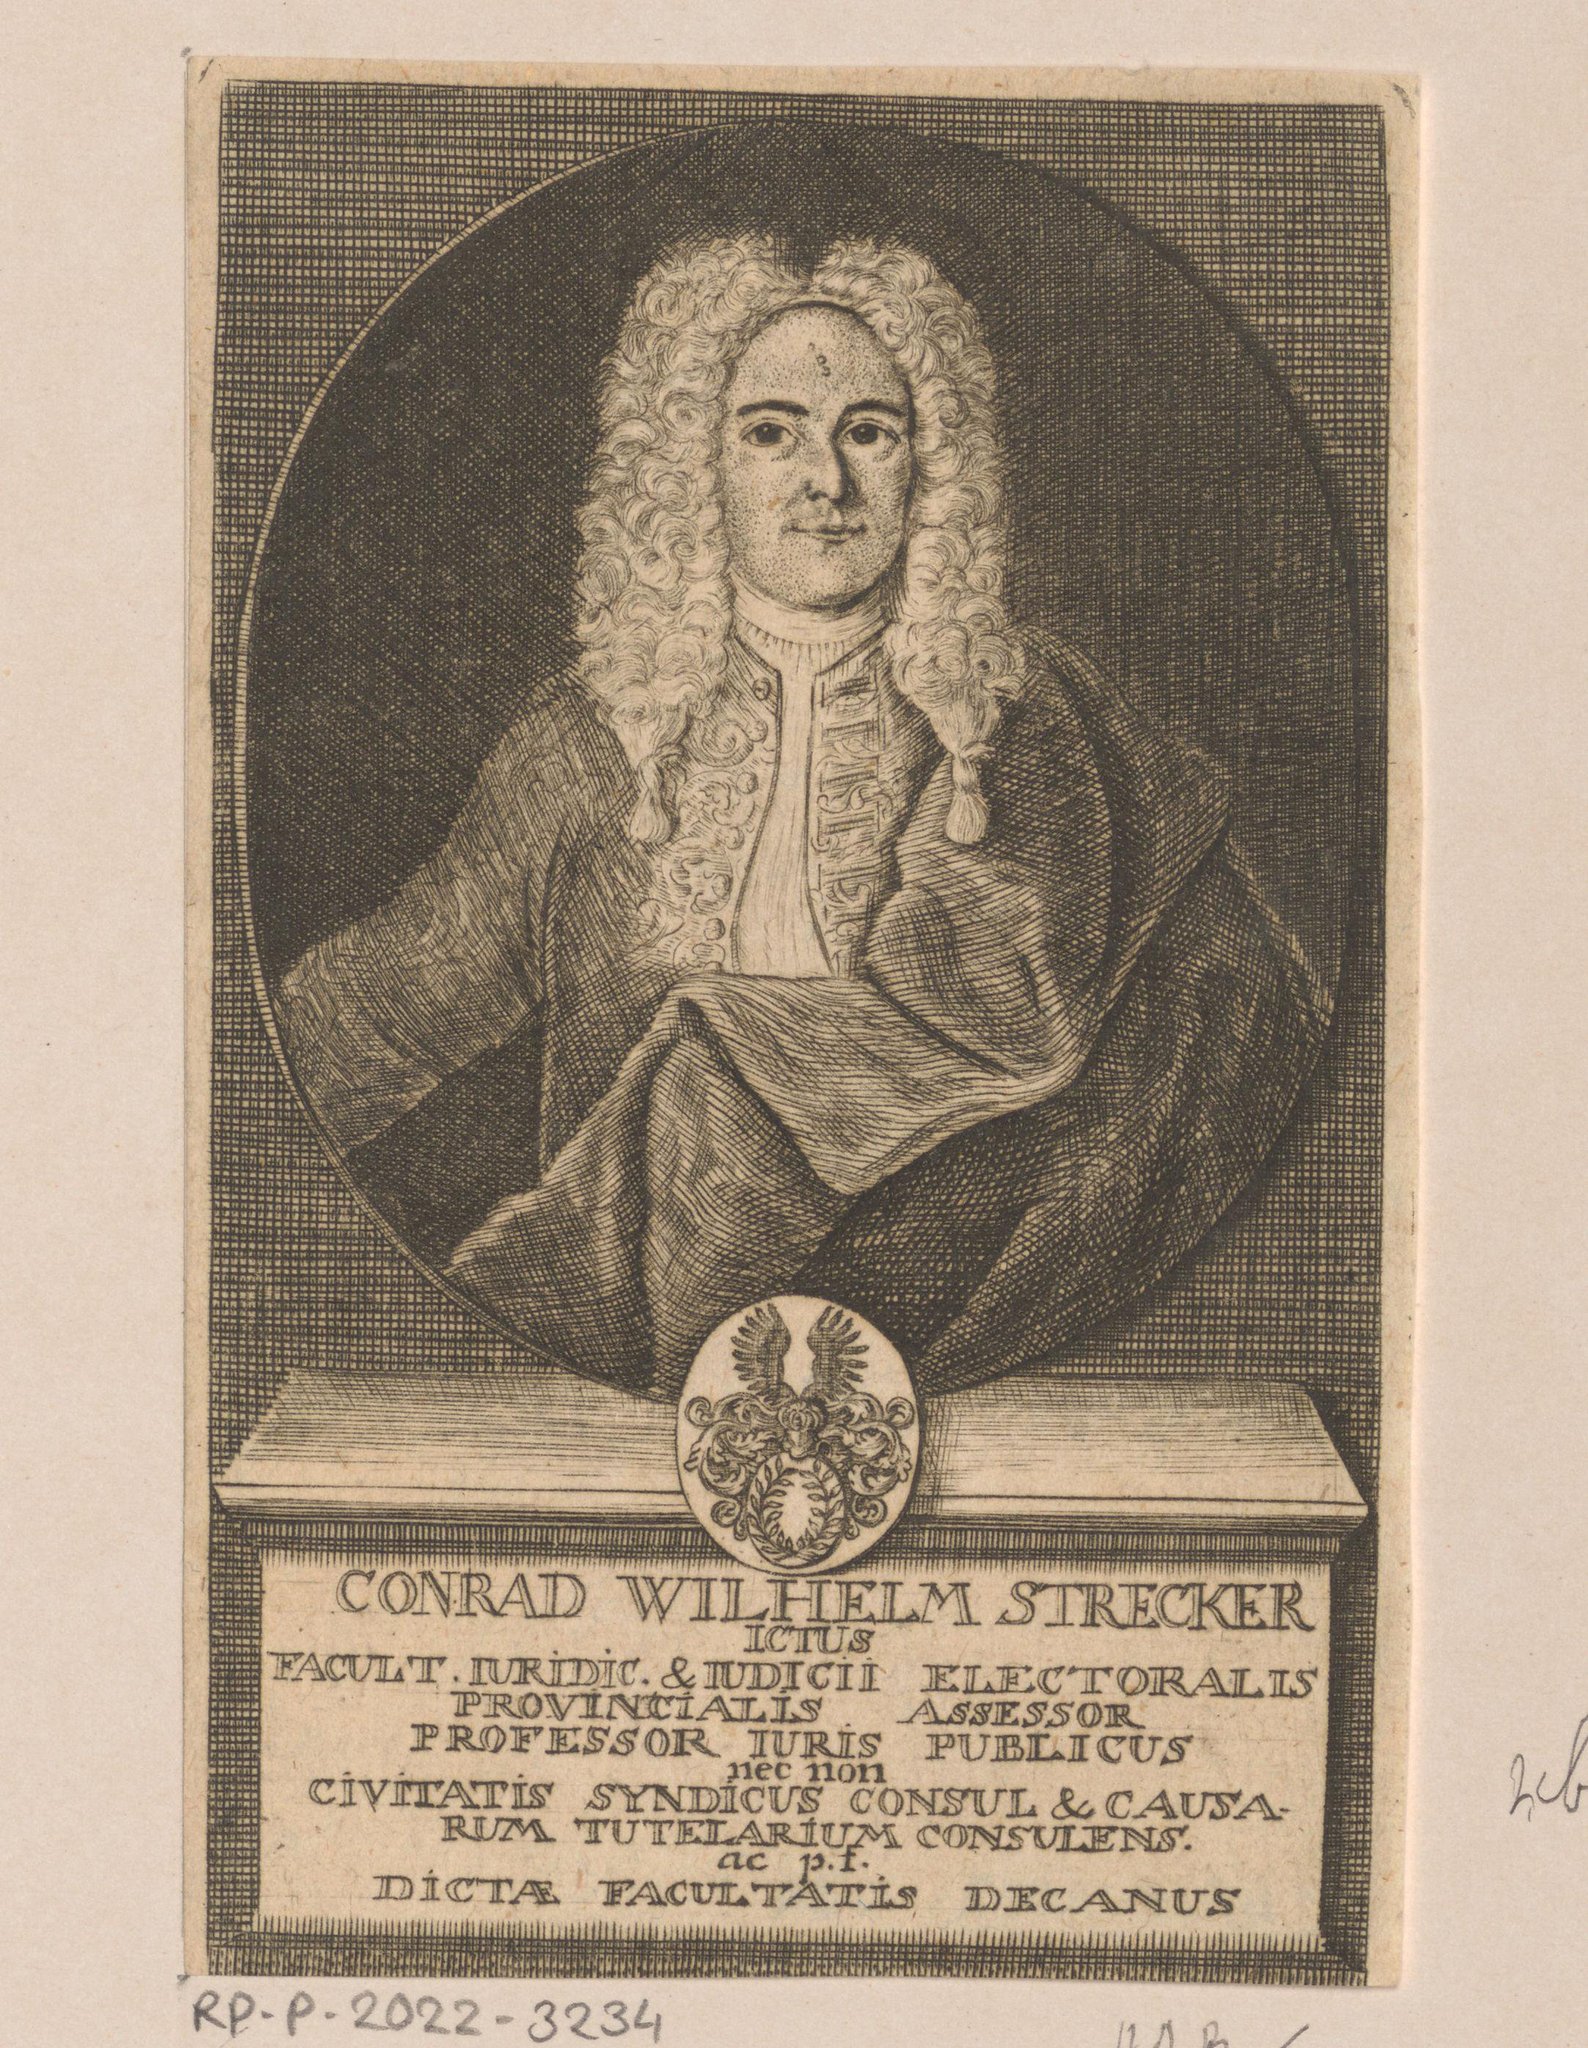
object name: print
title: Portret van Conrad Wilhelm Strecker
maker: Anonymous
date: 1734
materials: paper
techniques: engraving, etching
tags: historical persons, lawyer, attorney at law, professor, armorial bearing, heraldry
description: Prent waarschijnlijk uit: Motschmann, Just Christoph. Bey der Philosophischen Facultät Assossoris Extr. und Professoris Publici, Erfordia Literata Continuata oder Fortsetzung des Gelehrten Erffurths (...). S.l./Leipzig: Just Christoph Motschmann/Johann Christian Langenheim, 1734.